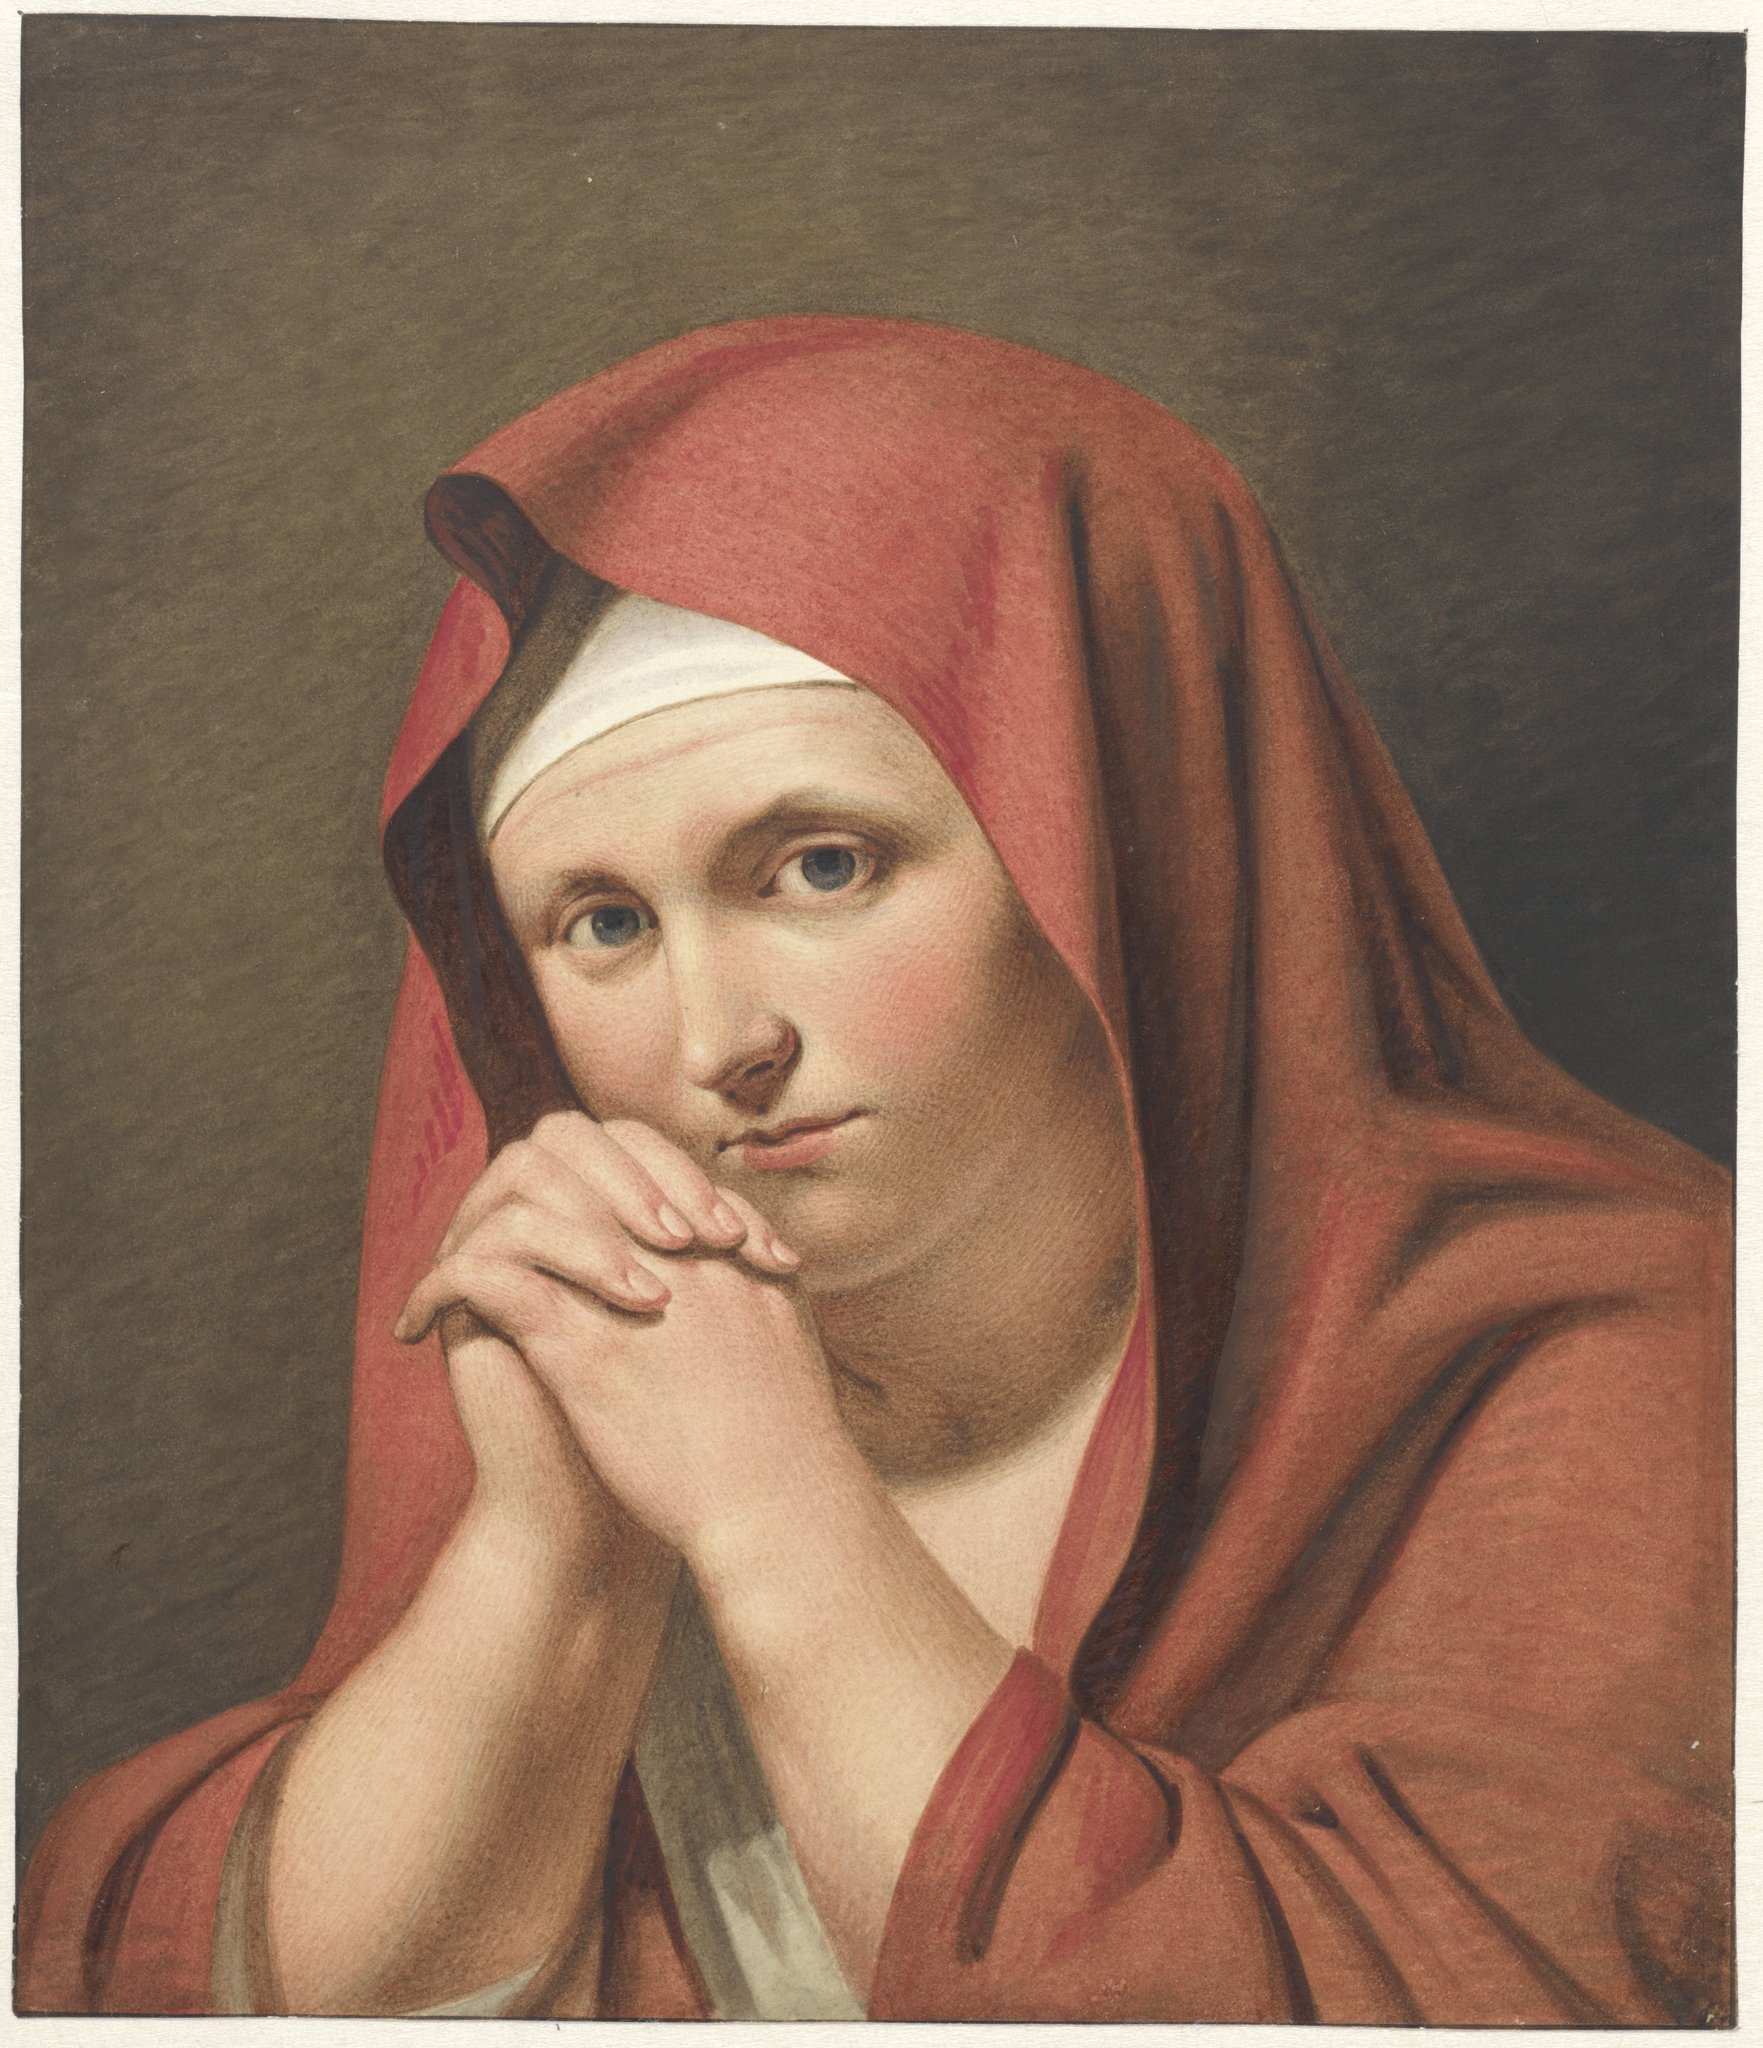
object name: drawing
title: Vrouw in het rood, met gevouwen handen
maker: cornelis kruseman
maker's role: draughtsman, painter, print maker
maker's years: 1797-1857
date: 1814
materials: paper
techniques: brush